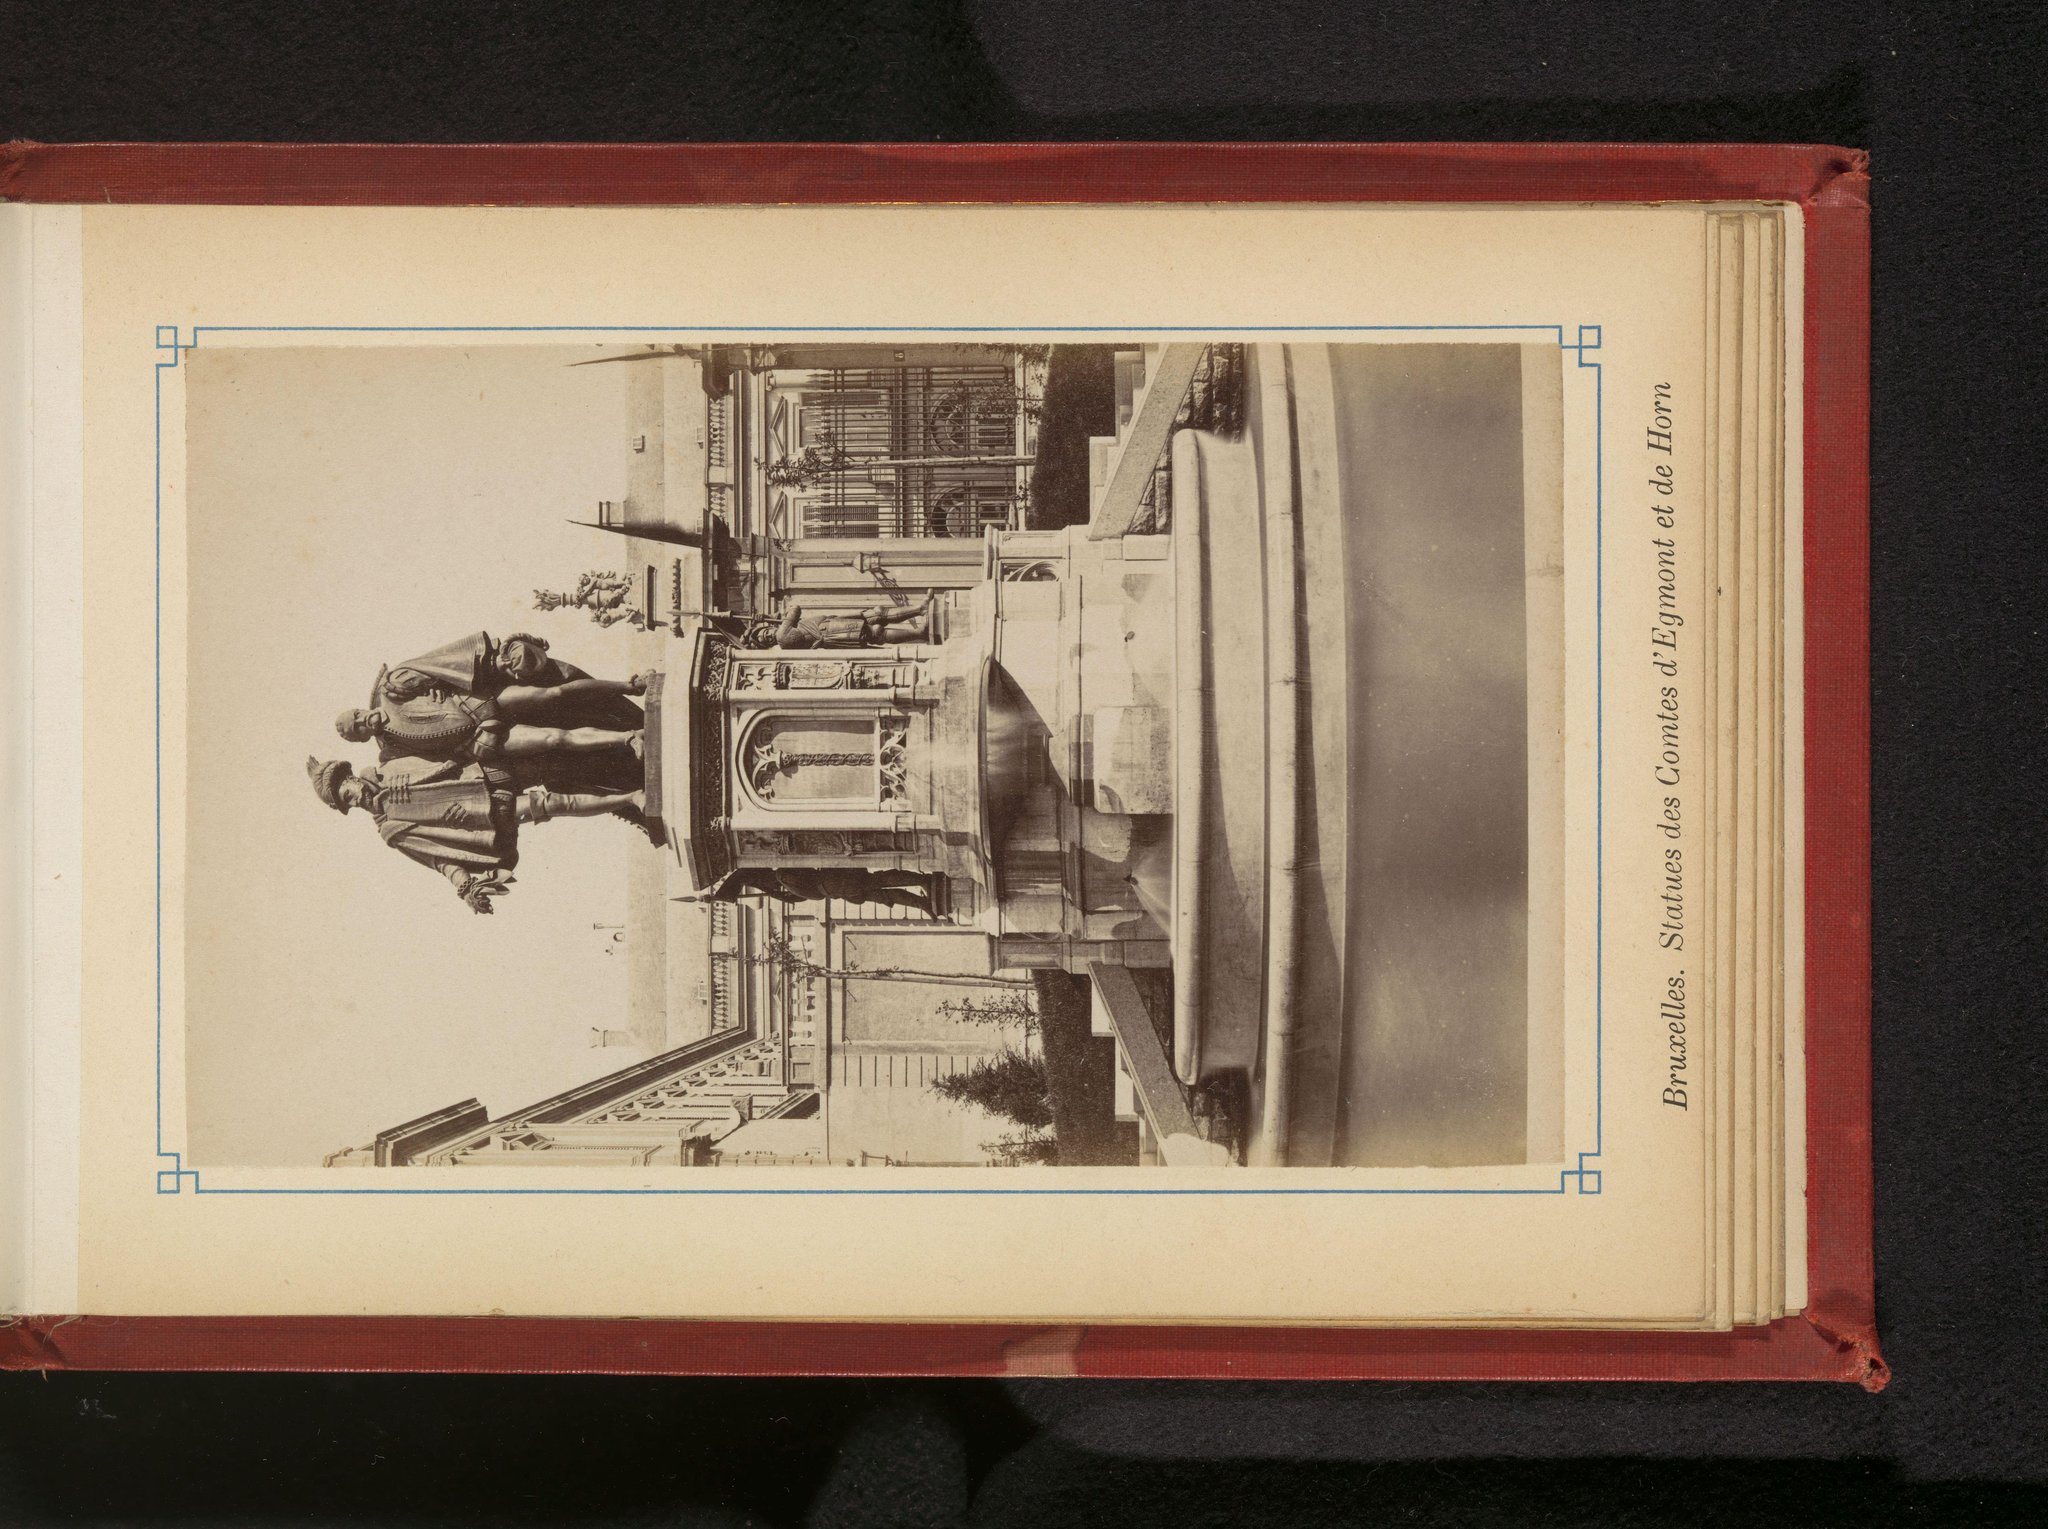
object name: page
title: Bruxelles. Statues des Comtes d'Egmont et de Horn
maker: Anonymous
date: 1875-1880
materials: photographic support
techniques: albumen print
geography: brussels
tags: brussels, earl, monument, statue, ornamental fountain